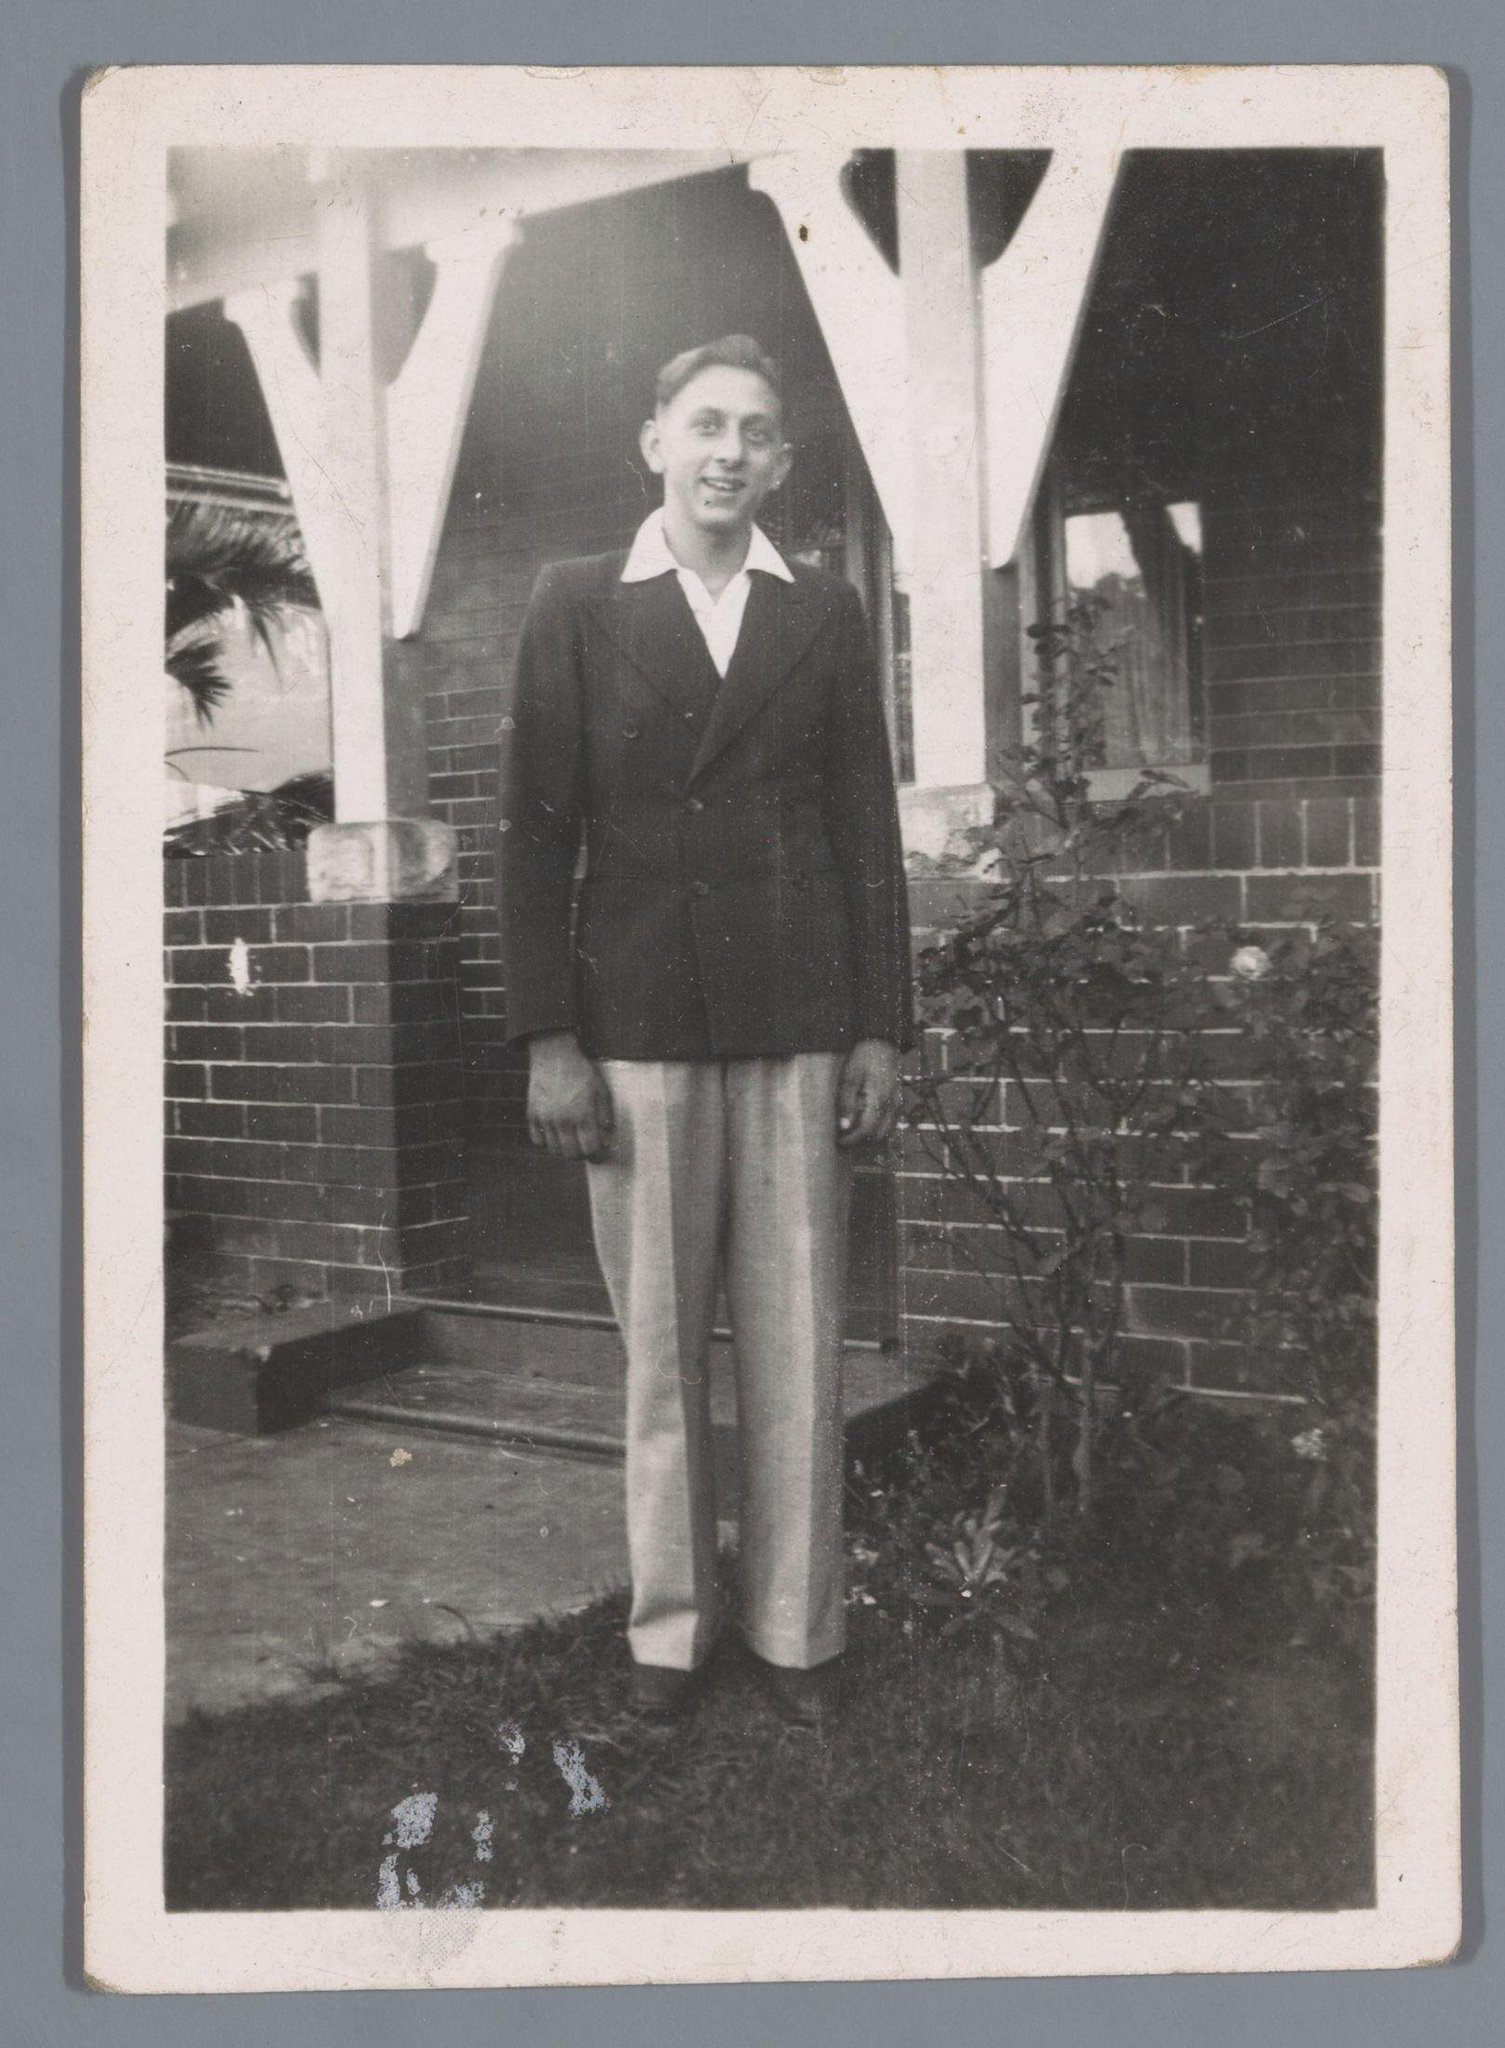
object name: photograph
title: Portret van een onbekende man in een voortuin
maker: Anonymous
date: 1924-1935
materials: photographic support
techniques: gelatin silver print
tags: youth, adolescent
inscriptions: number: ‘67’, inscription: ‘He was on leave + ehanged his elathe This is Reg Just before he went to [...] New Britian’